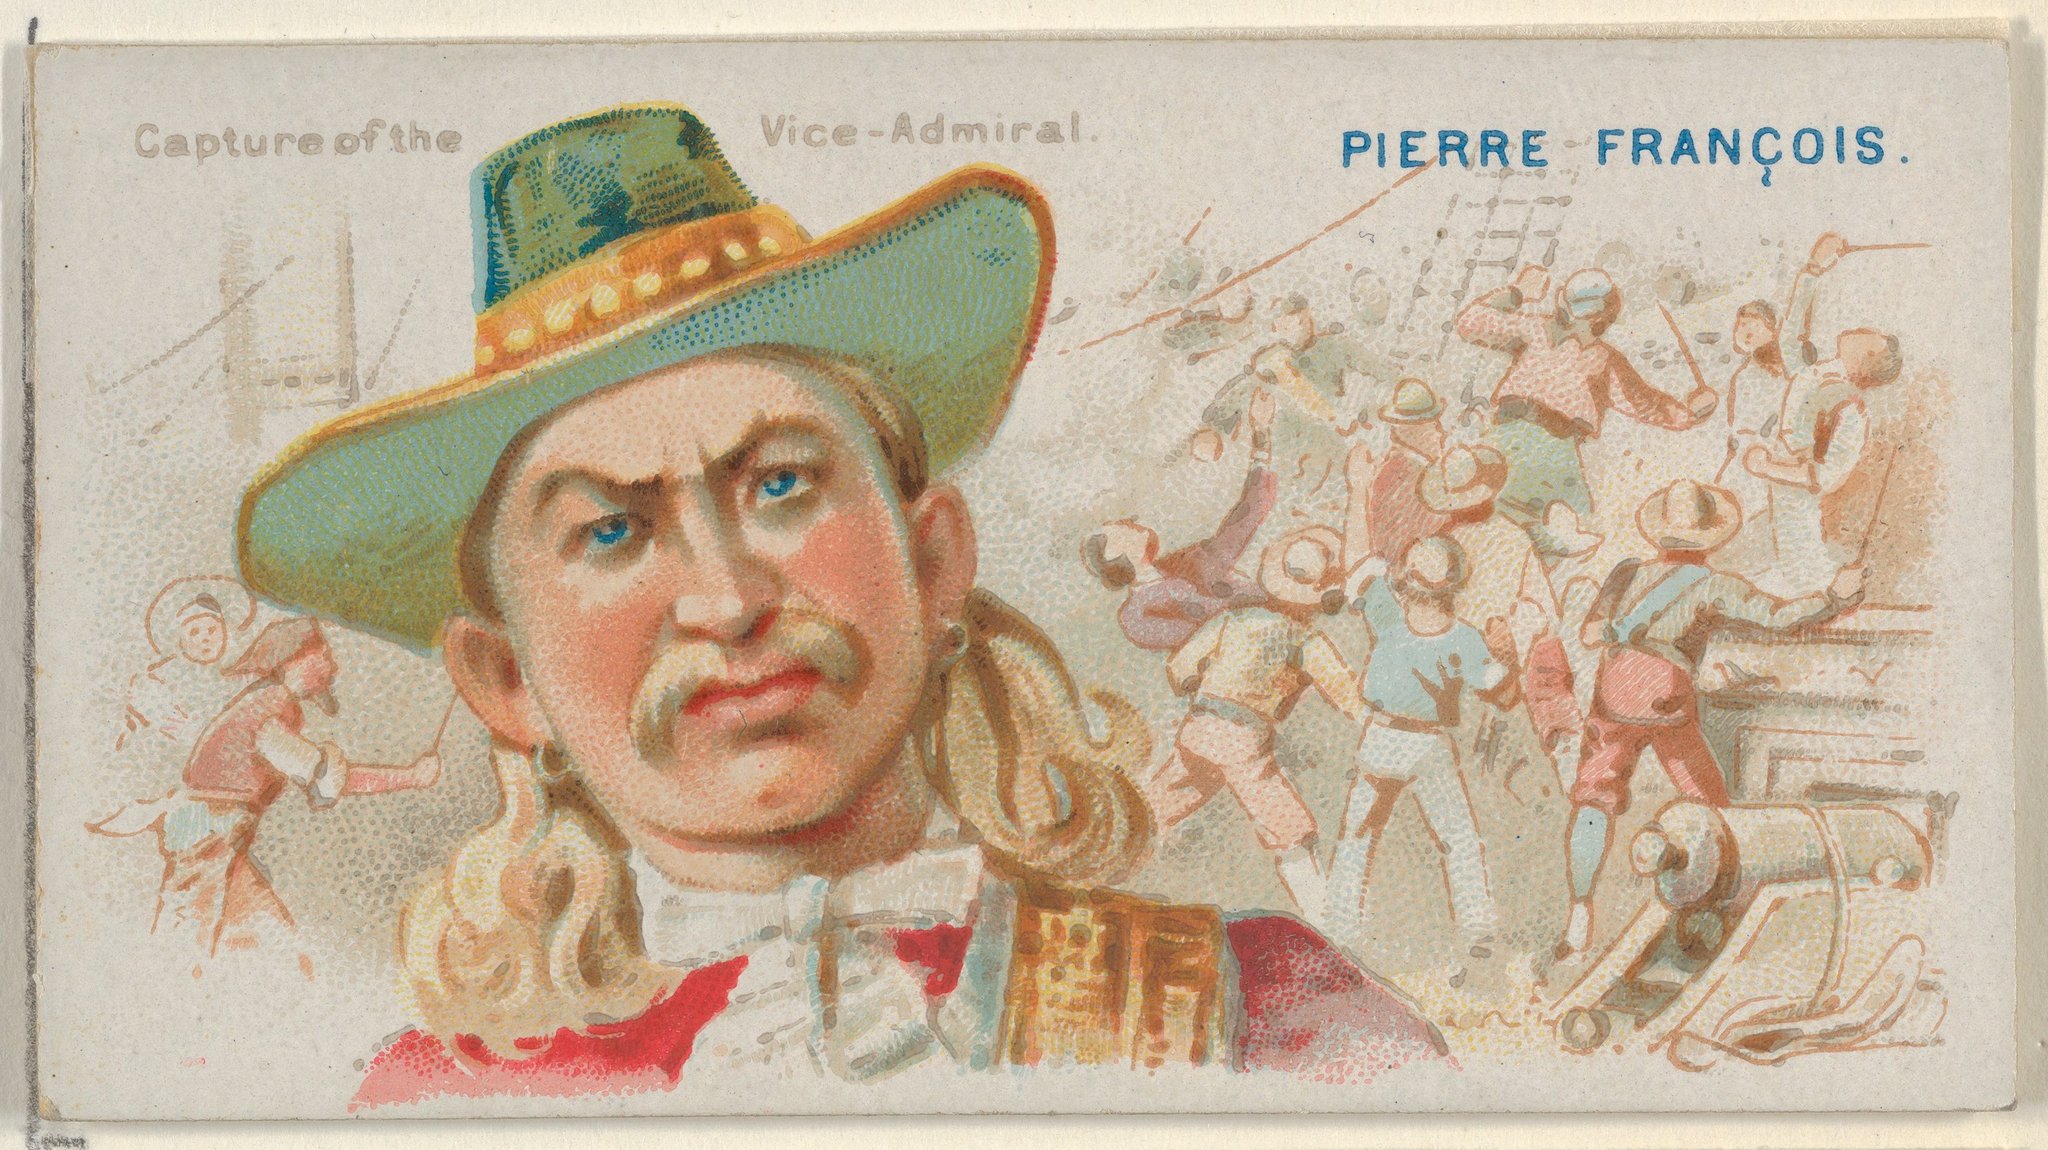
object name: print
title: Pierre François, Capture of the Vice-Admiral, from the Pirates of the Spanish Main series (N19) for Allen & Ginter Cigarettes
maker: allen & ginter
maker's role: publisher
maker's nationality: american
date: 1888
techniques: color lithograph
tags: men